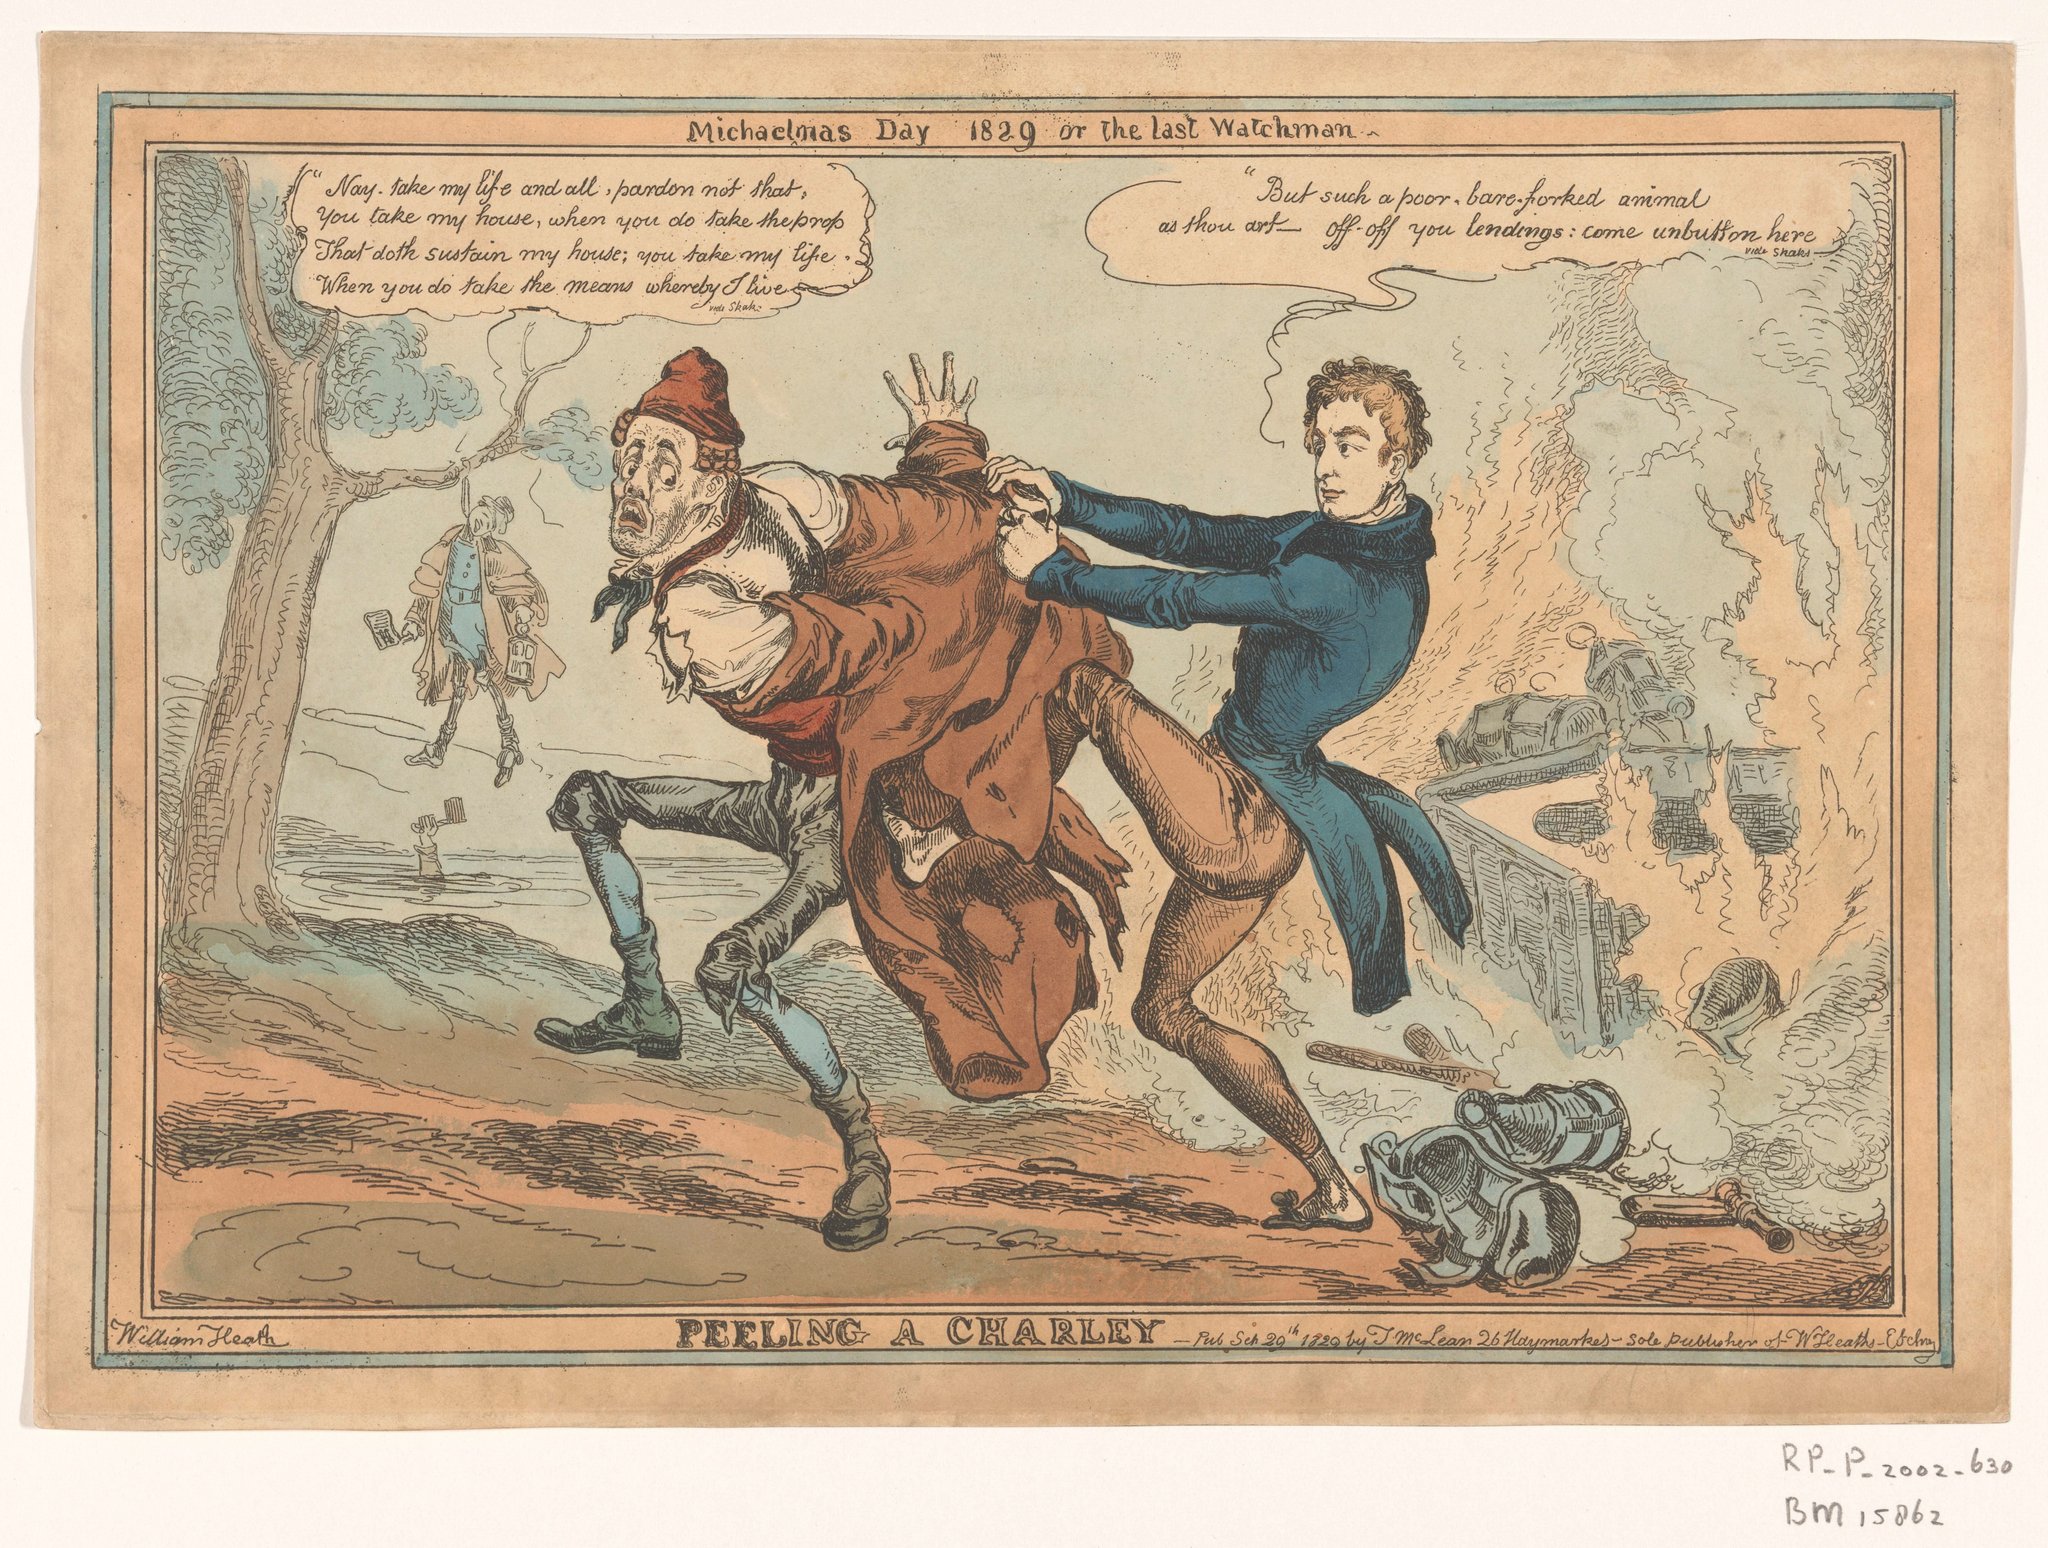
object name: cartoon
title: Peeling a Charley / Michaelmas Day 1829 or the last Watchman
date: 1829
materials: paper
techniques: etching, hand coloring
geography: london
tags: london, night patrol, coat: overcoat, political caricatures and satires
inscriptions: collector's mark: Lugt 2228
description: Spotprent op Sir Robert Peel waarin Peel de jas trekt van de rug van een arme nachtwacht (ratelwacht). Rechts een vuur waarin de lantaarns en ratels van de wachten worden verbrand.